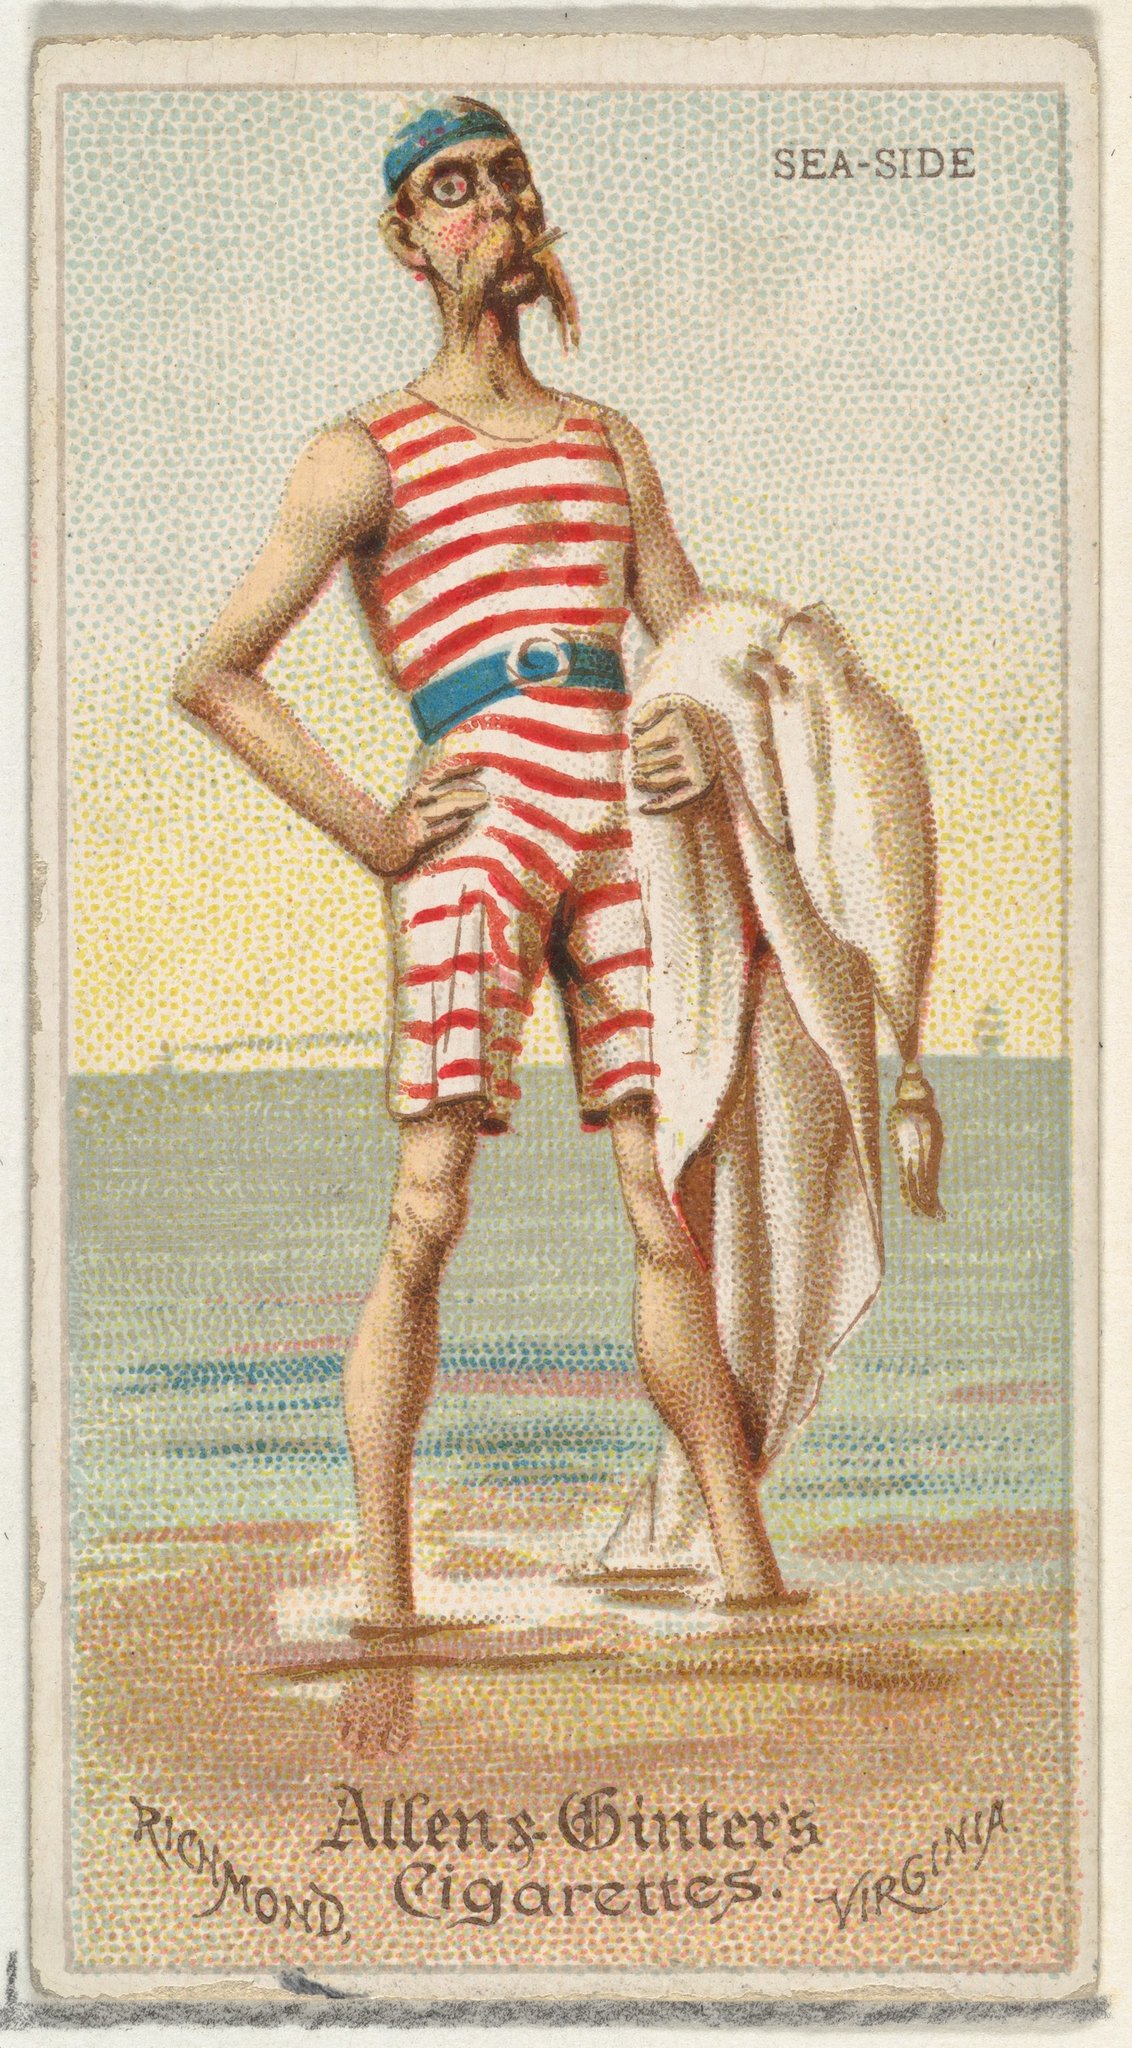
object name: print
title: Sea-Side, from World's Dudes series (N31) for Allen & Ginter Cigarettes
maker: allen & ginter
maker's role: publisher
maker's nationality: american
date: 1888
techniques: color lithograph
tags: men